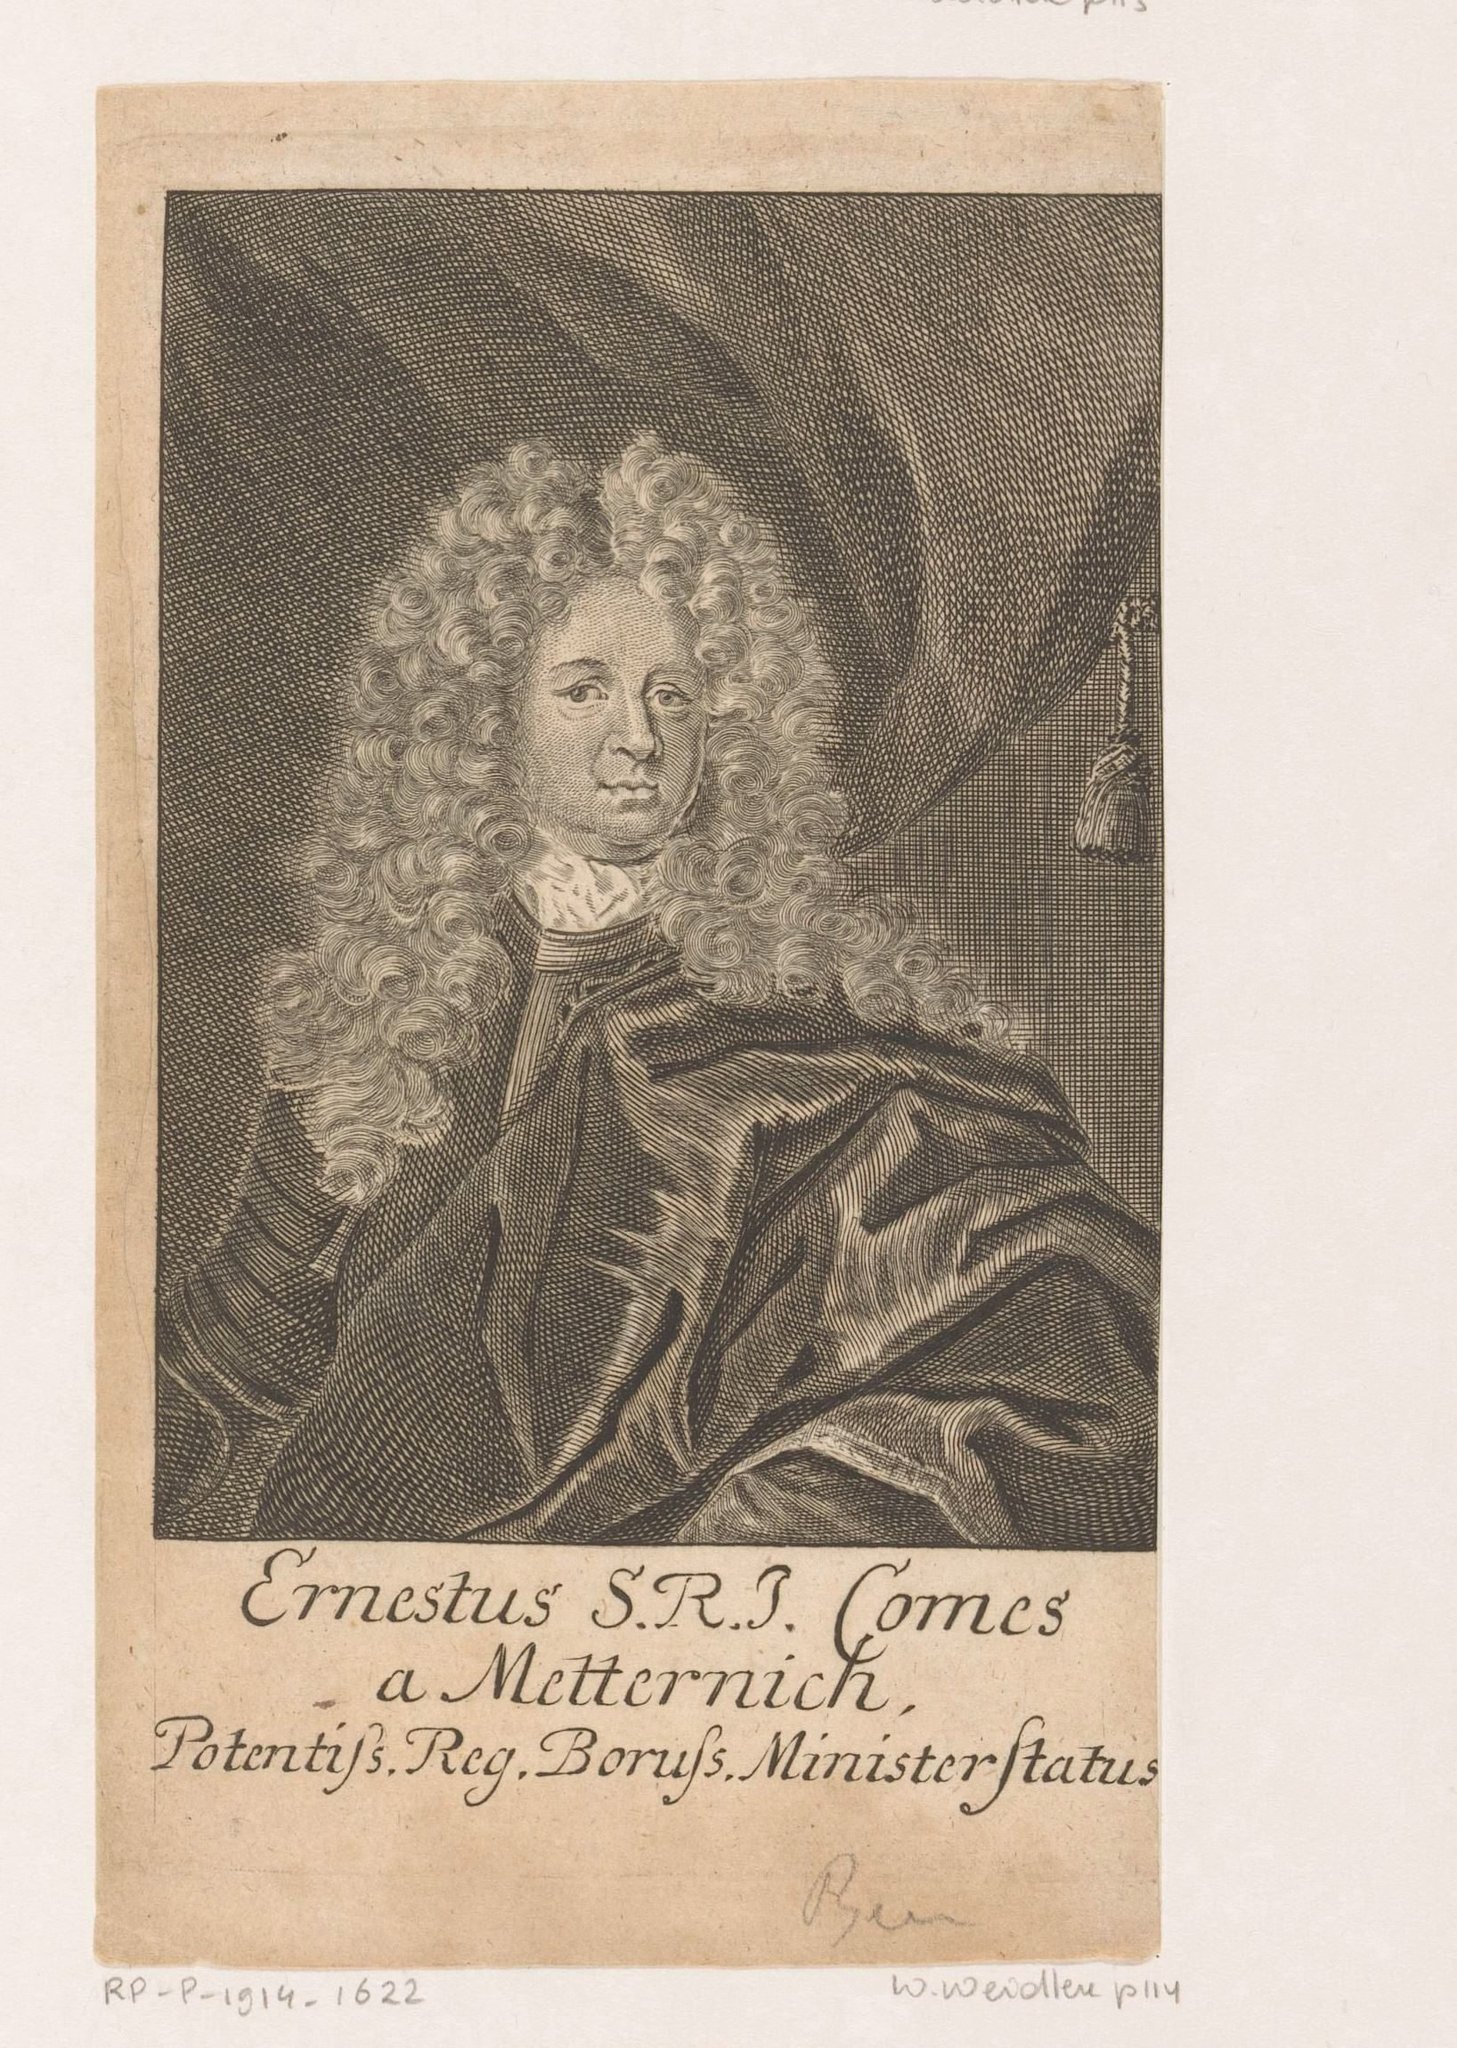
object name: print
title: Portret van Ernst Graf von Metternich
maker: martin bernigeroth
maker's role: print maker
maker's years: 1670-1733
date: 1713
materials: paper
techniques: engraving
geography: leipzig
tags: historical persons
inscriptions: collector's mark: Lugt 2228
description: Prent ook gebruikt in: Die Europäische Fama, Welche den gegenwärtigen Zustand der vornehmsten Höfe entdecket. dl. 150. Leipzig: Gleditsch, 1713.